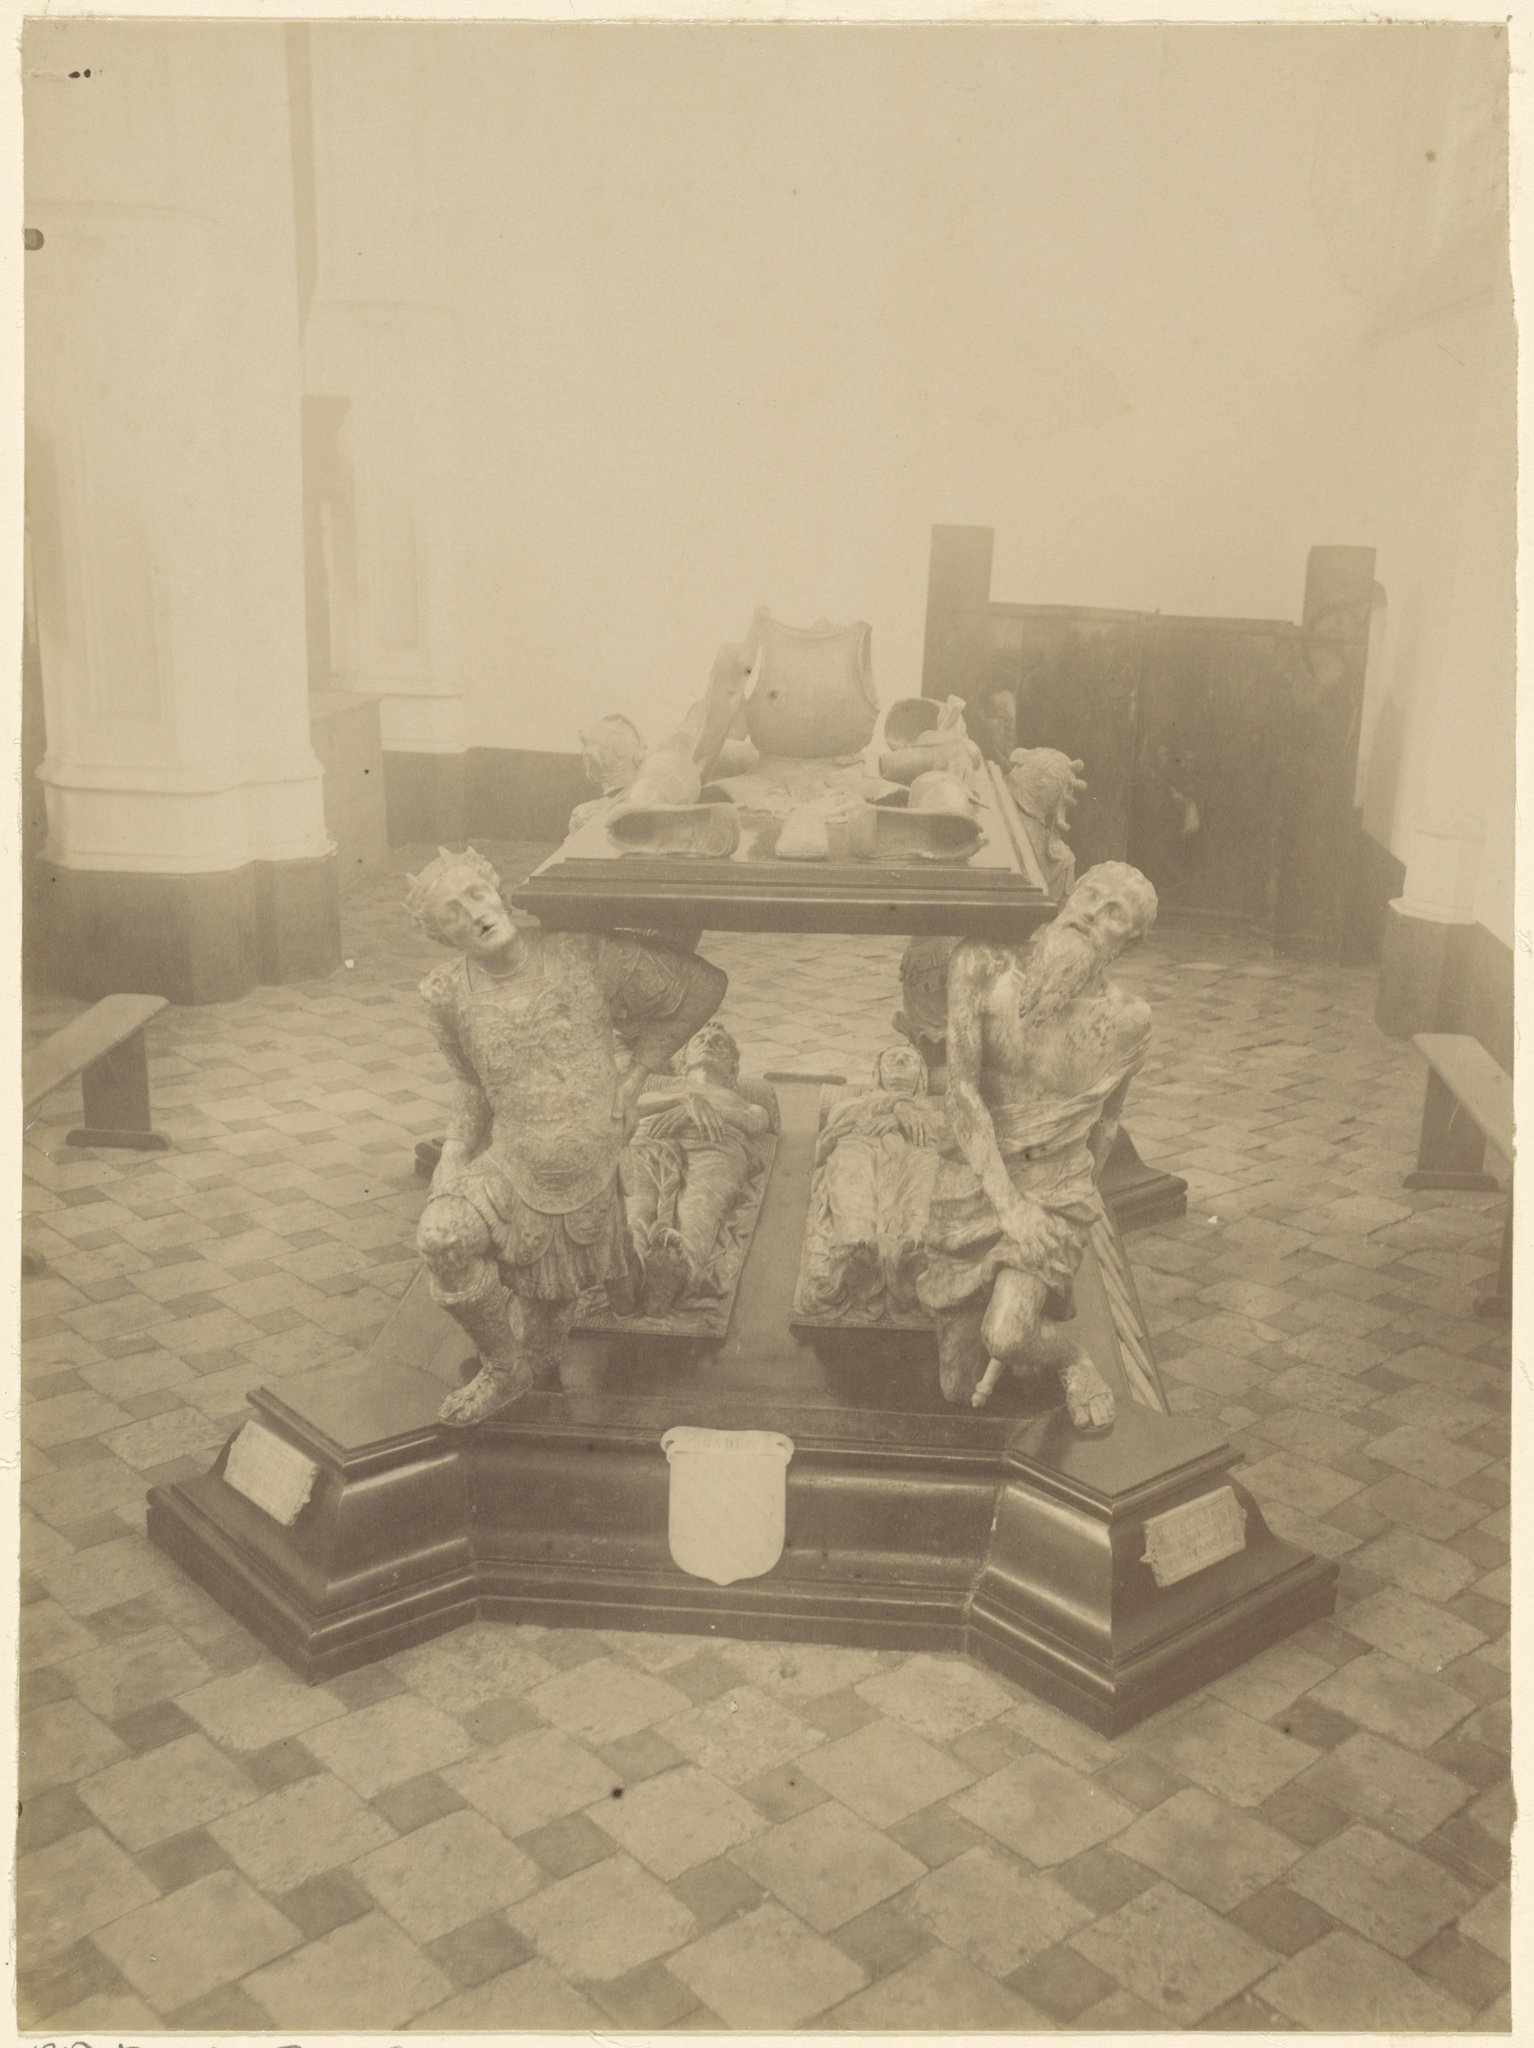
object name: photograph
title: Grafmonument voor Engelbrecht II, graaf van Nassau-Dillenburg-Breda, 1504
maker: Anonymous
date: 1850-1930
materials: photographic support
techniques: photography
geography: netherlands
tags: interior of church, grave-building, monumental tomb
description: De hier vermelde titel verwijst naar de hoogst verkregen titel van de geportretteerde, niet per se naar de titel die de geportretteerde op deze voorstelling draagt.